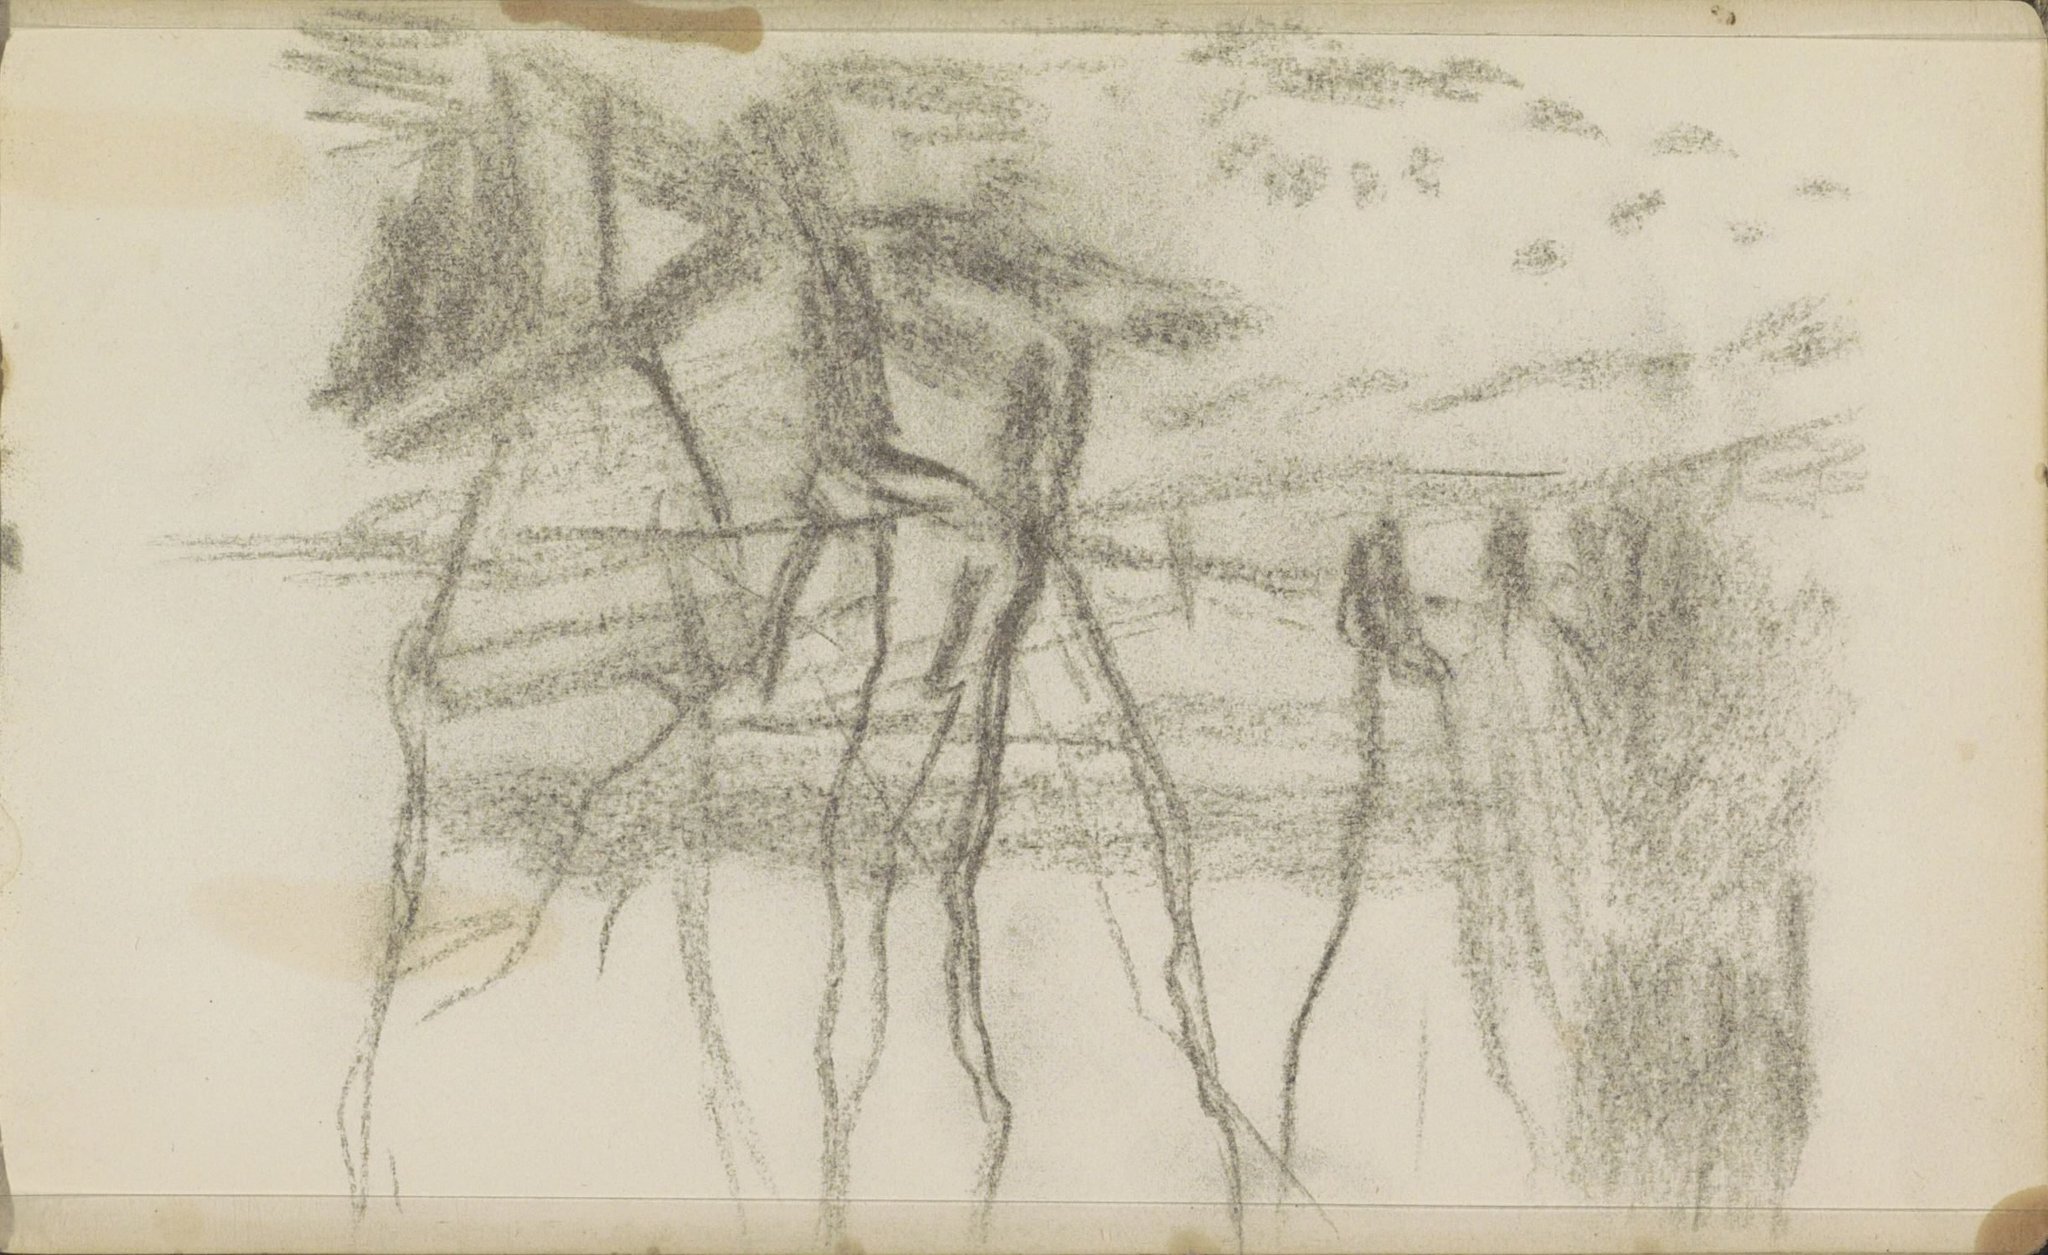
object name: sketchbook leaf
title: Bomen langs een landweg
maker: jozef israëls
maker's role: draughtsman, painter, print maker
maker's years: 1824-1911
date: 1834-1911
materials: chalk, paper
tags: trees, road, path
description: Blad 39 recto uit een schetsboek met 42 bladen.